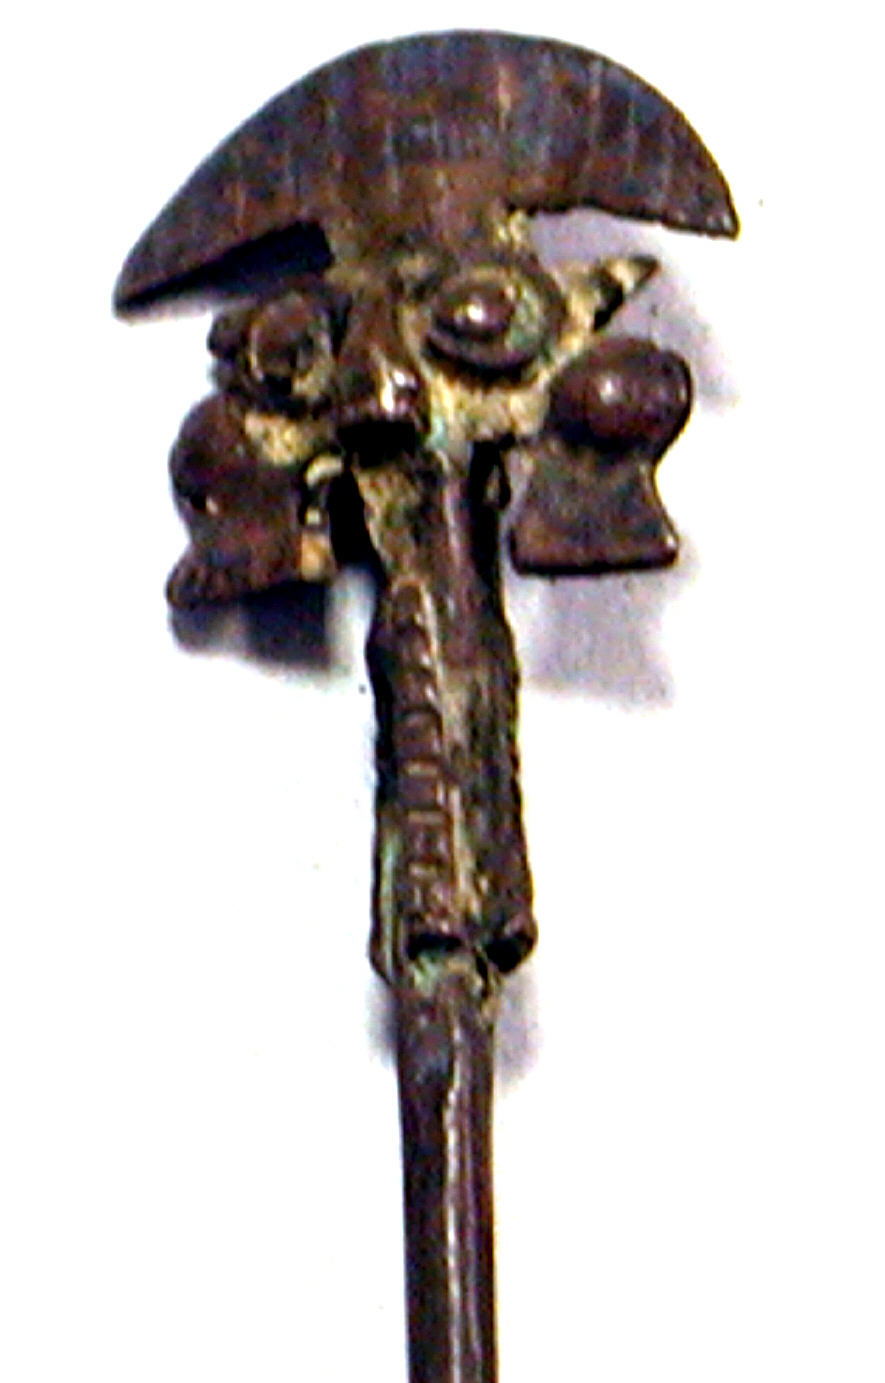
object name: pin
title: Silver Pin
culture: inca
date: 1401-1600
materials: silver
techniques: hammering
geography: peru